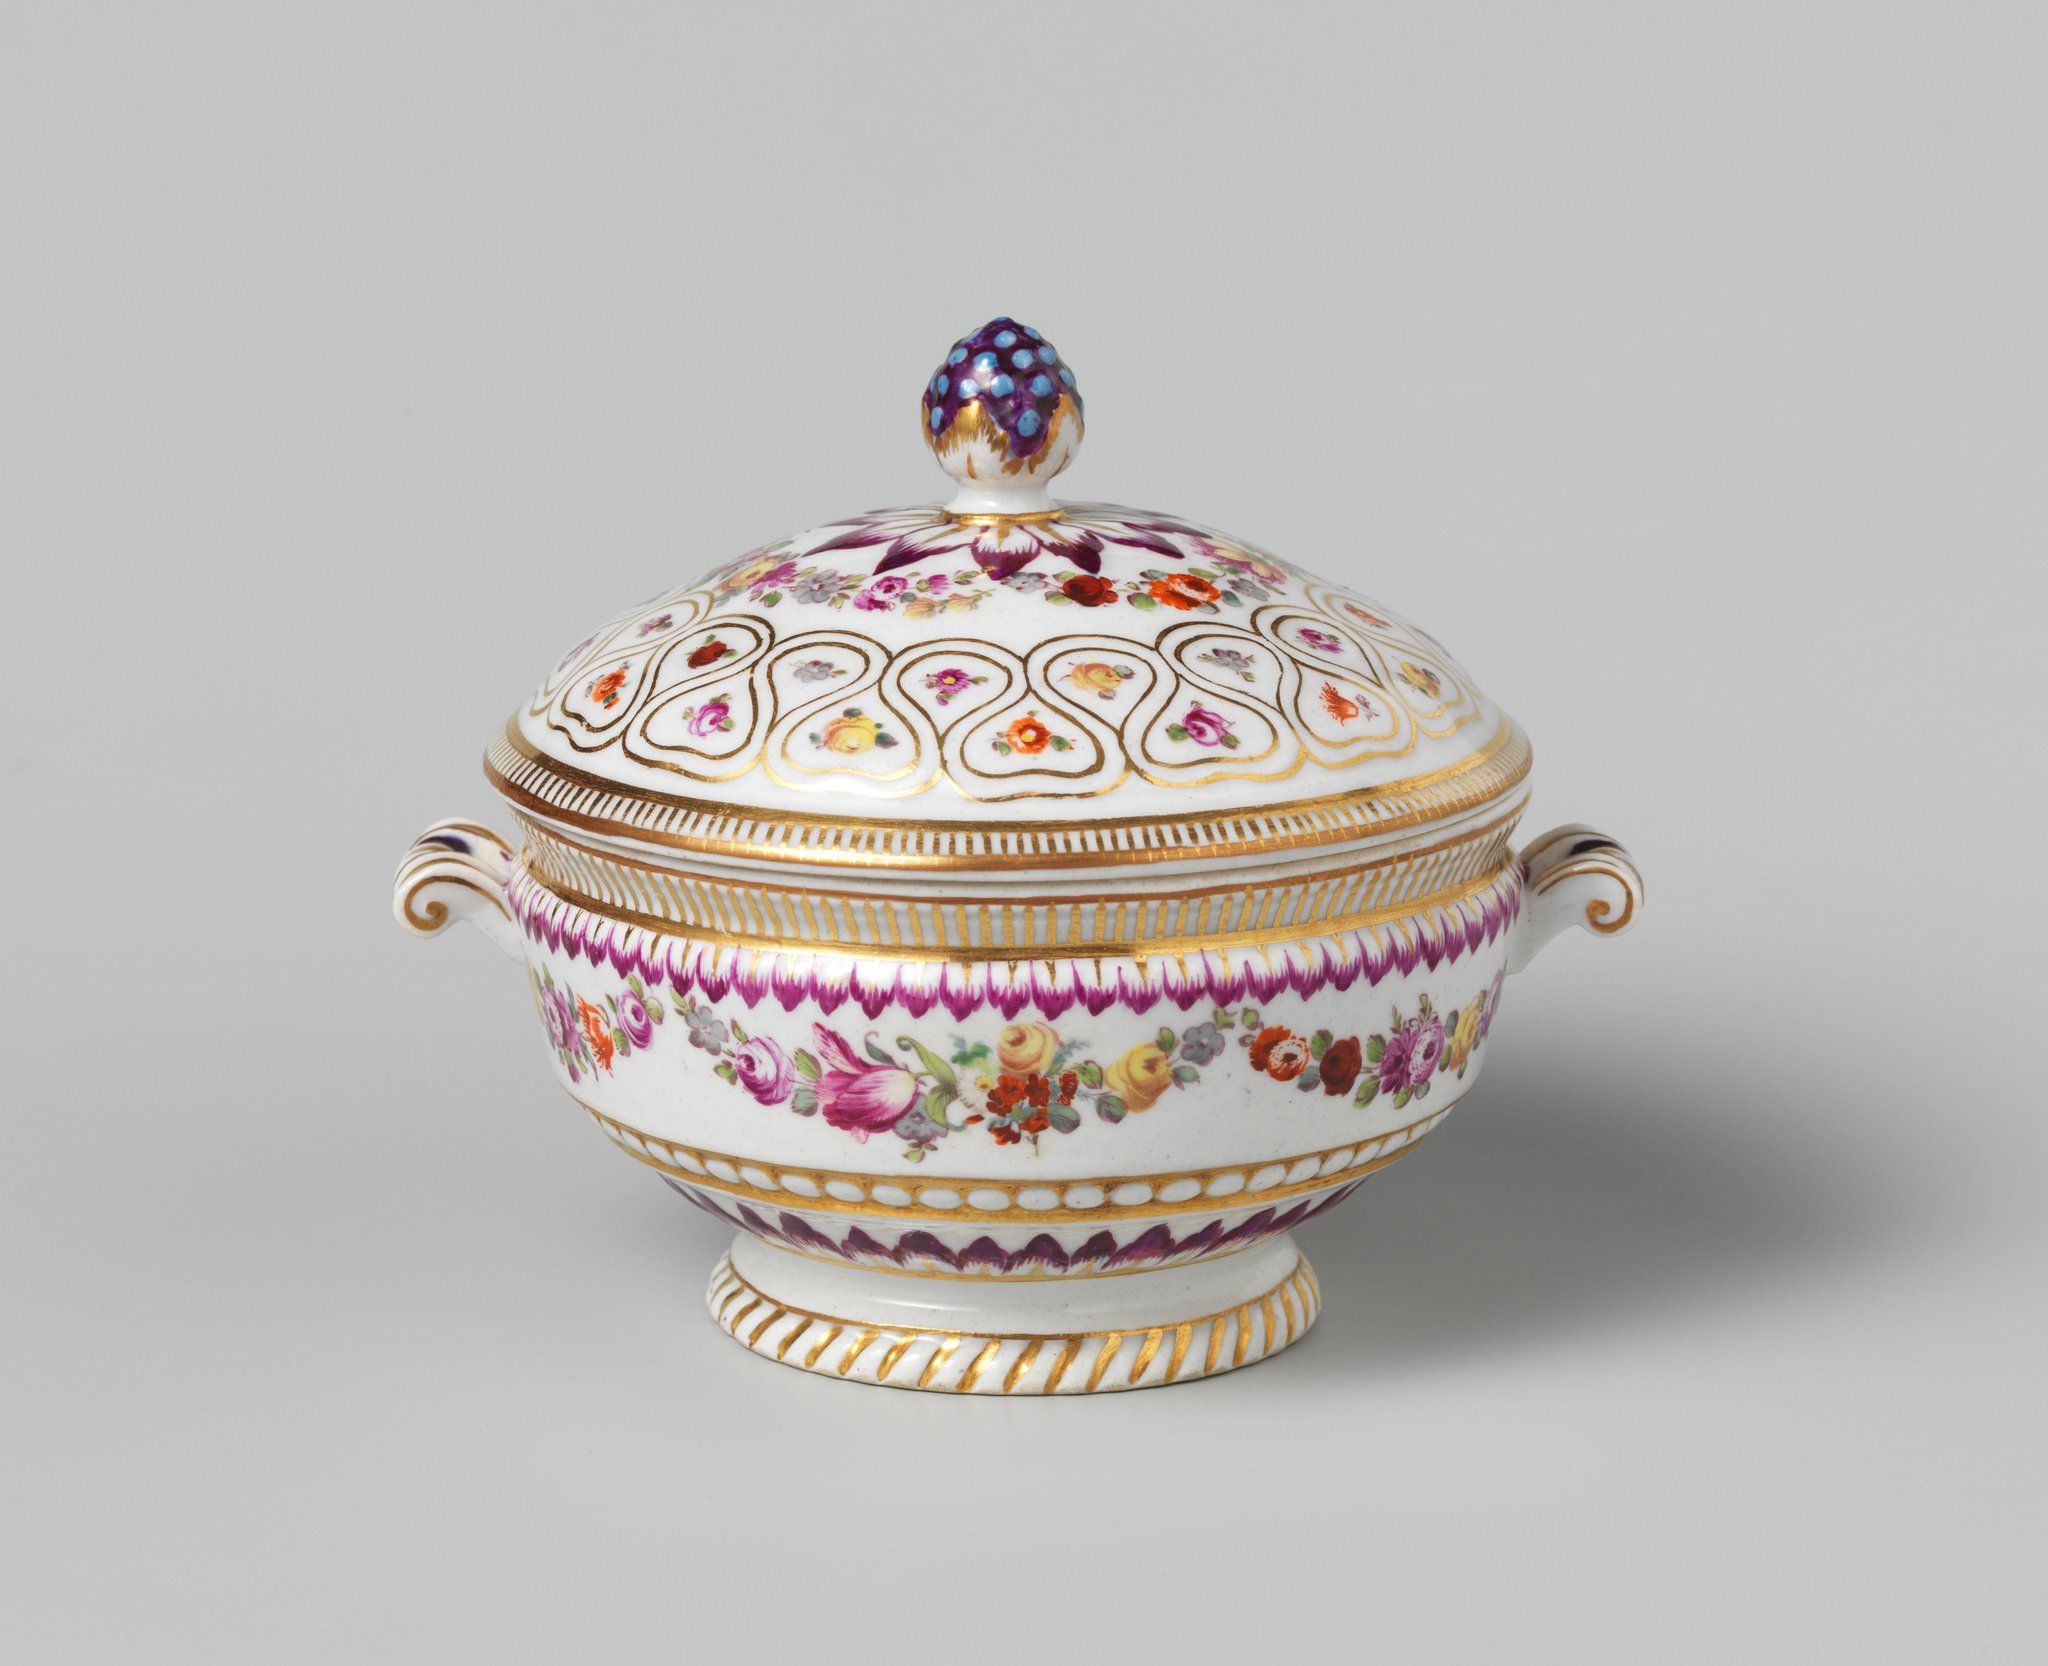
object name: sugar box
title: Deksel van suikerpot beschilderd met guirlandes en bloemen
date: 1778-1782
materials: porcelain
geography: loosdrecht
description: Op het deksel zijn veelkleurige strooibloempjes geschilderd binnen een sterk kronkelend goud gerand lint. Rond de dekselknop een rozet in reliëf, beschilderd in blauw, paars en goud, waaromheen veelkleurige bloemguirlandes. De knop zelf is beschilderd in blauw, paars en goud.